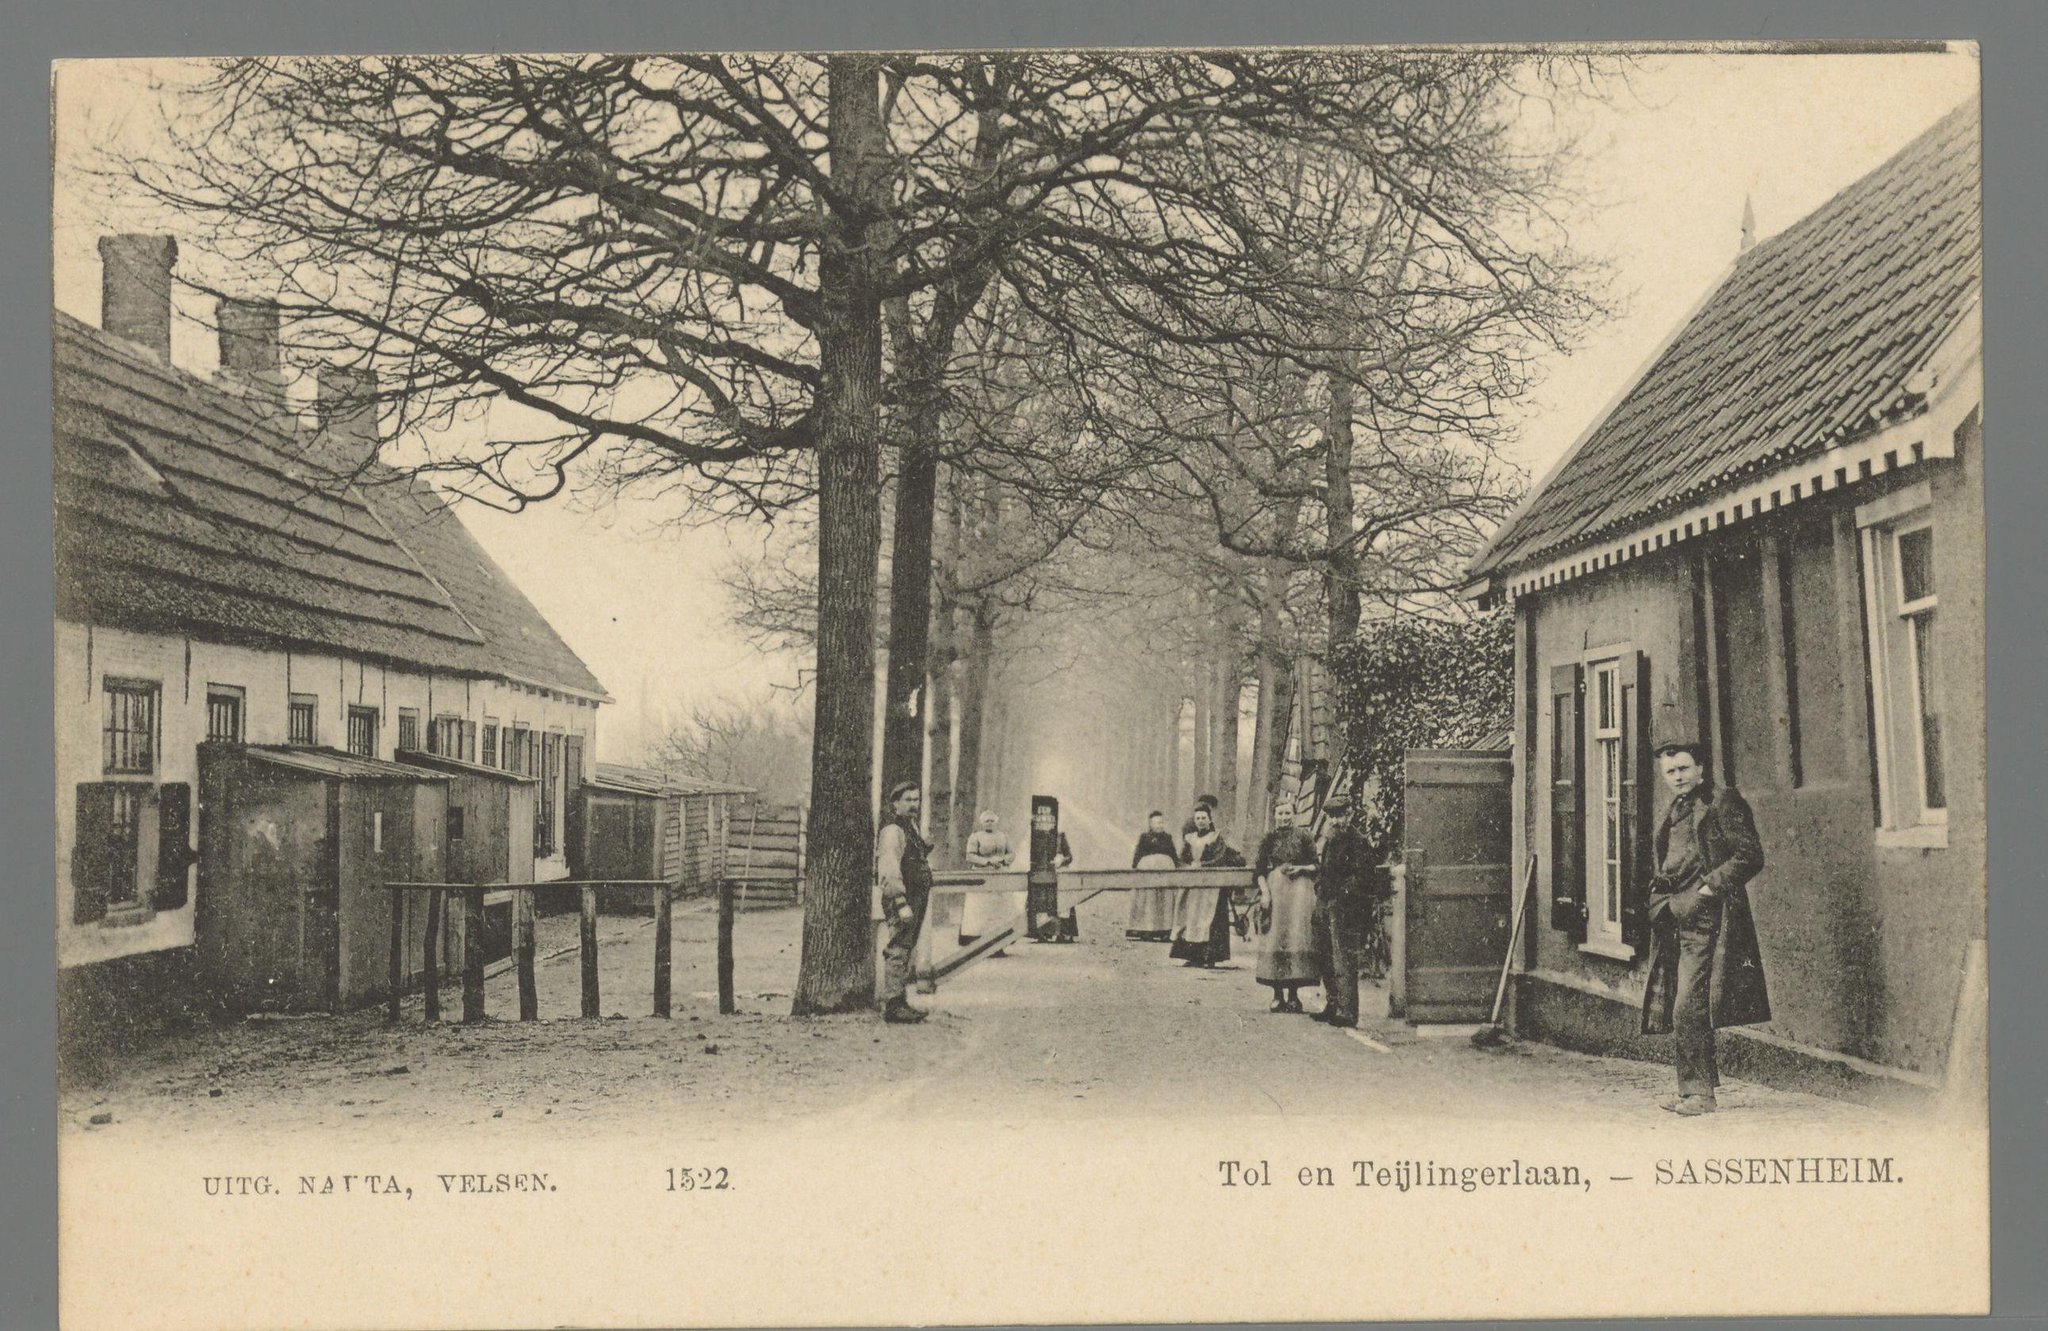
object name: ansichtkaart, prentbriefkaart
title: Tol en Teijlingerlaan, - Sassenheim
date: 1897-1905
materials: cardboard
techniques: photograph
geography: velsen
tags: toll gate, street